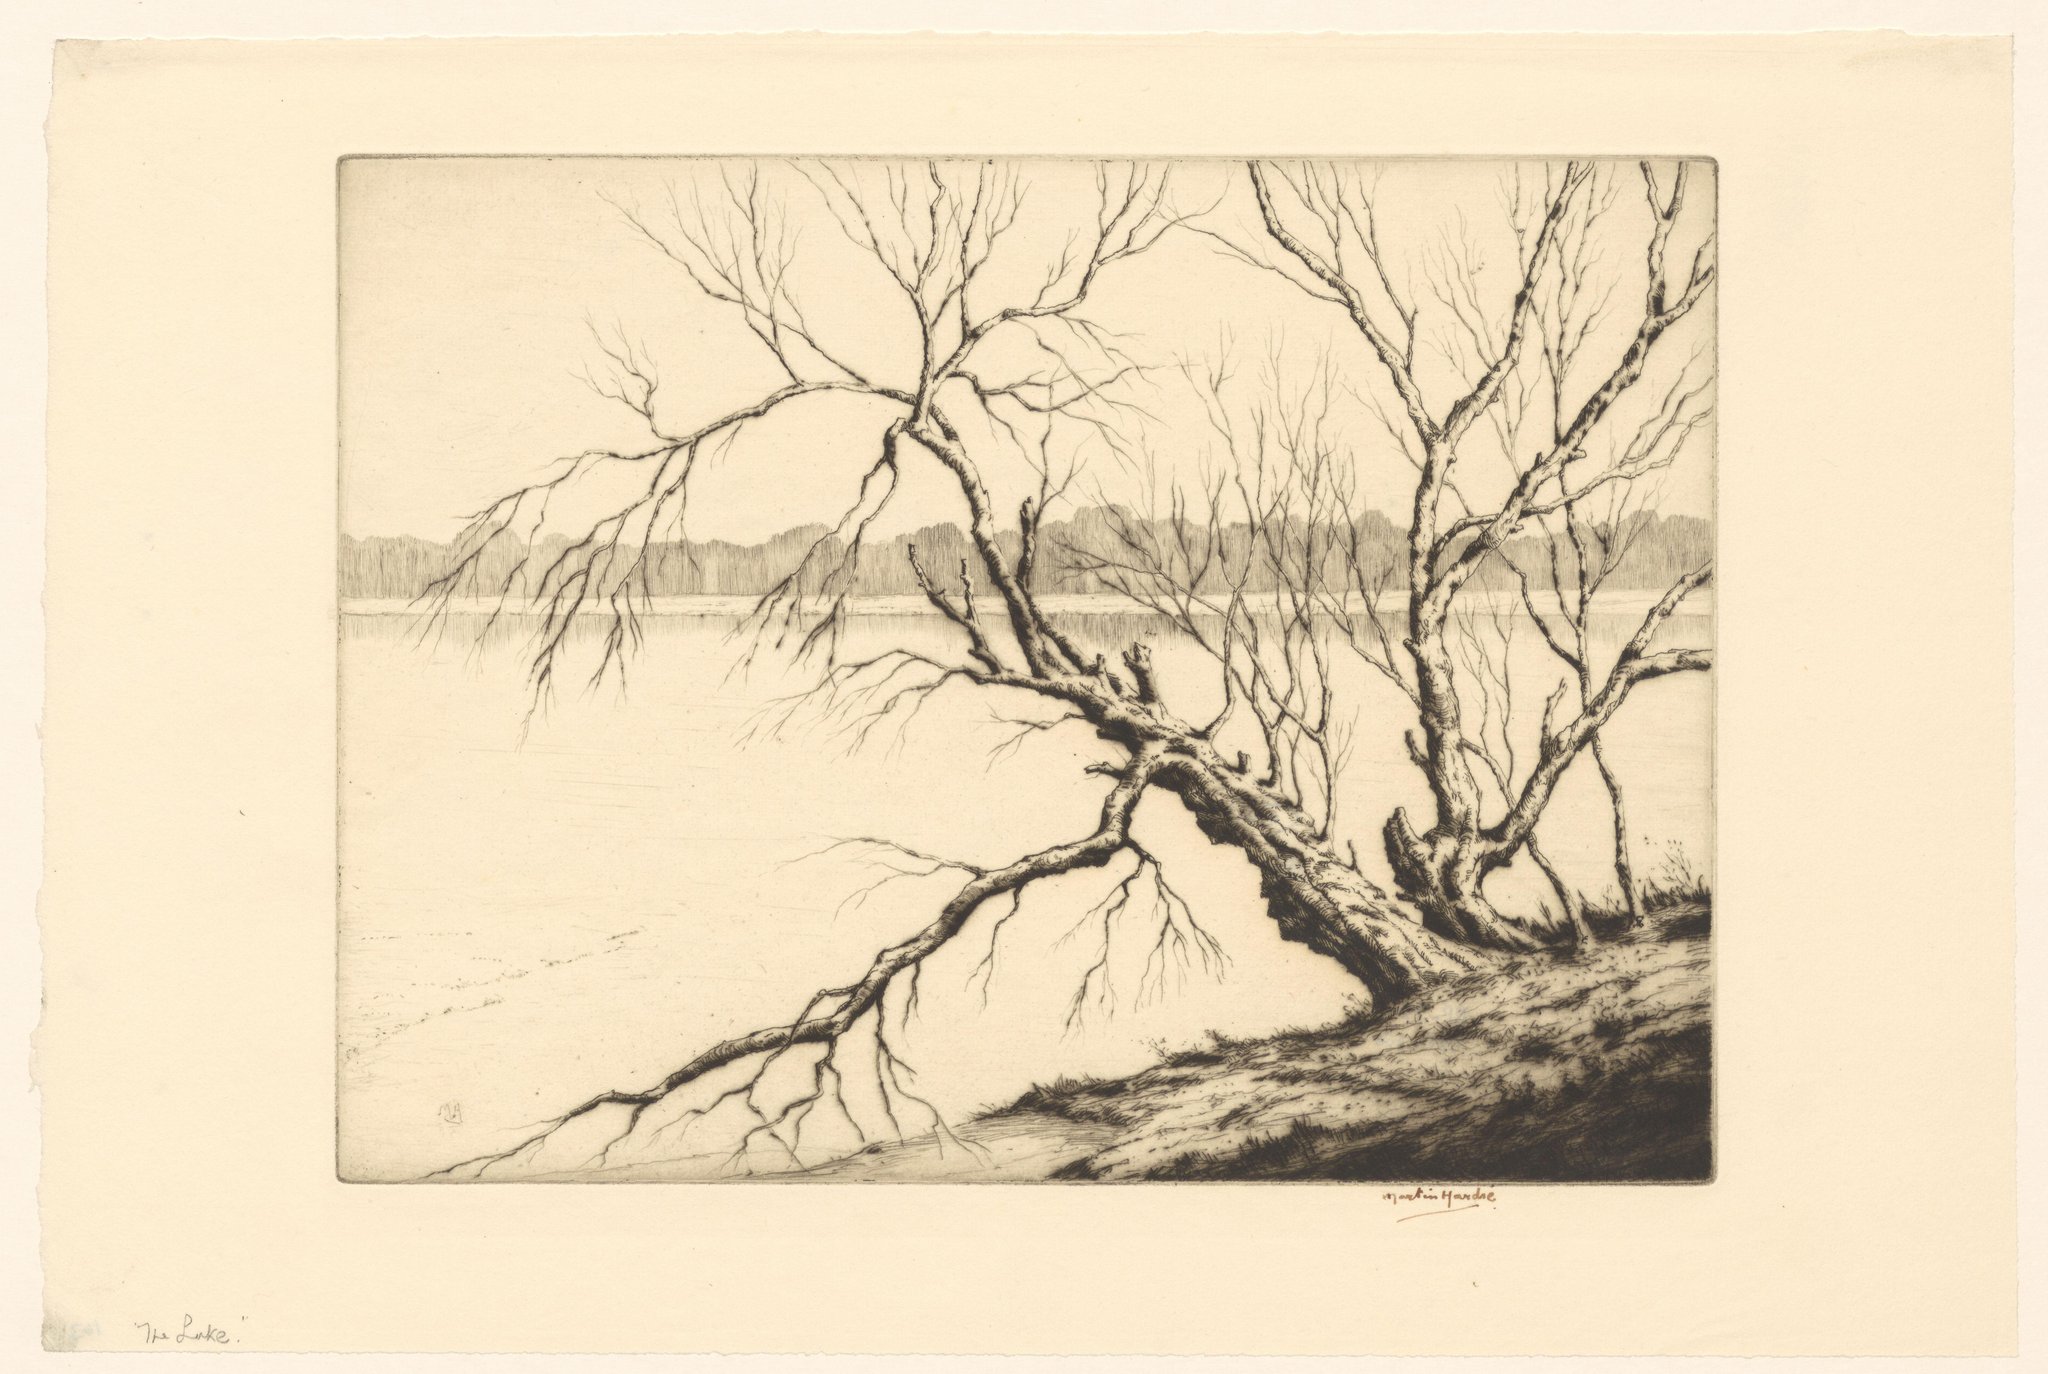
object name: print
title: The Lake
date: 1937-1945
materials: paper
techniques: drypoint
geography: maresfield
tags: lake (+ landscape with figures, staffage)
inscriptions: collector's mark: Lugt 2228, collector's mark: Lugt 2760, annotation: ‘Martin Hardie’